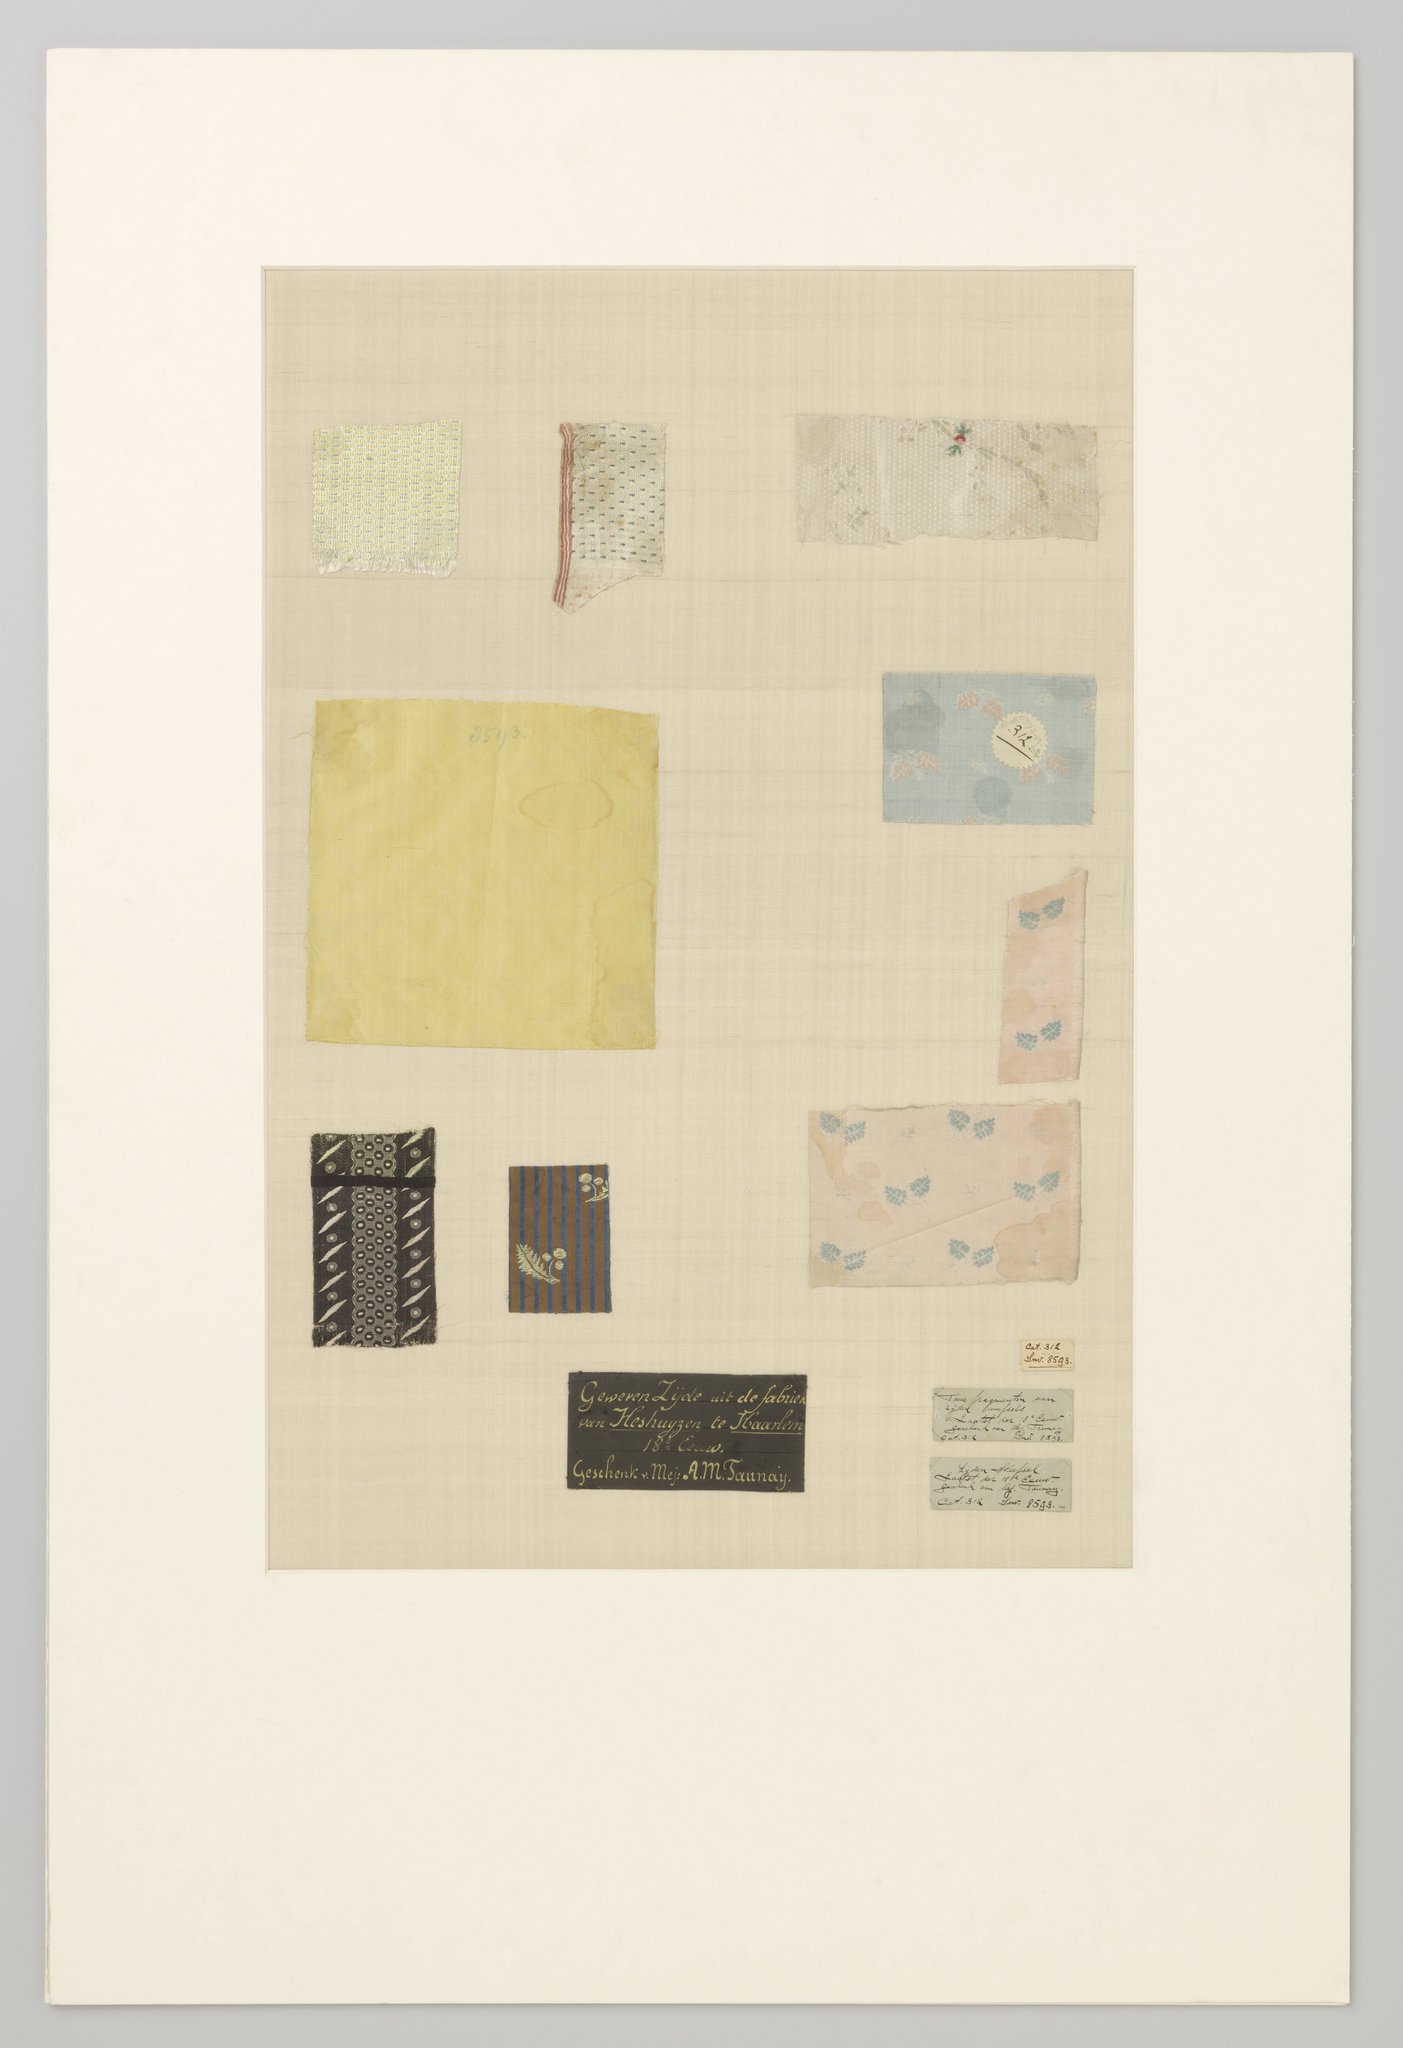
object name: fragment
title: Fragment zijdeweefsel.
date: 1750-1800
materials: silk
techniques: brocade, weave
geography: haarlem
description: Fragment zijdeweefsel. Een roze grond heeft twee dubbele blauwe bladeren op een witte steel, waartussen een kleine witte tak.